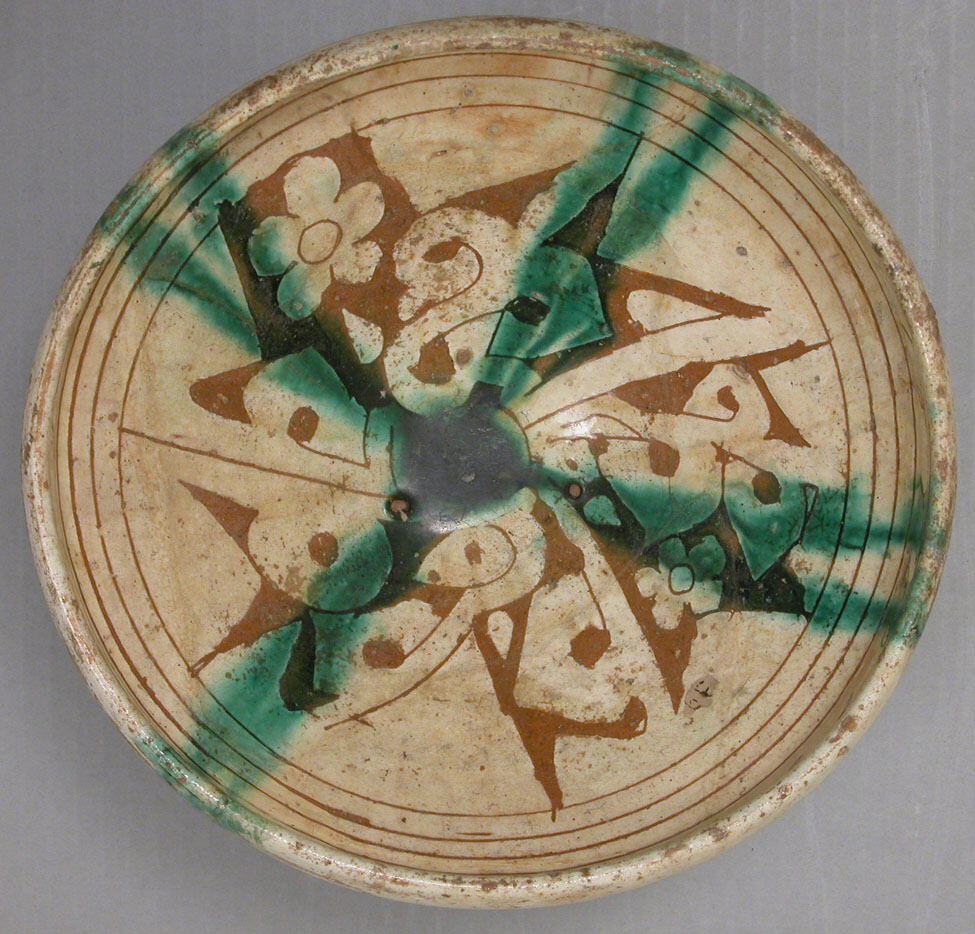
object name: bowl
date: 1167-1300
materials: earthenware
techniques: glazing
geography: iran